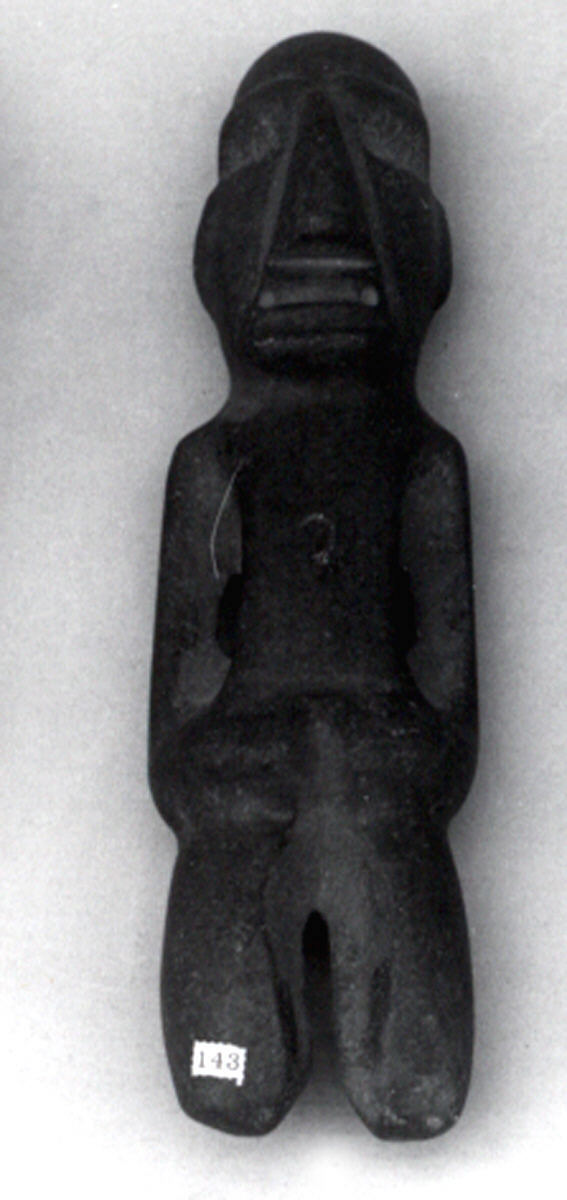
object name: figure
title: Standing Figure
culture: guerrero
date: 1-800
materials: stone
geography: mexico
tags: human figures